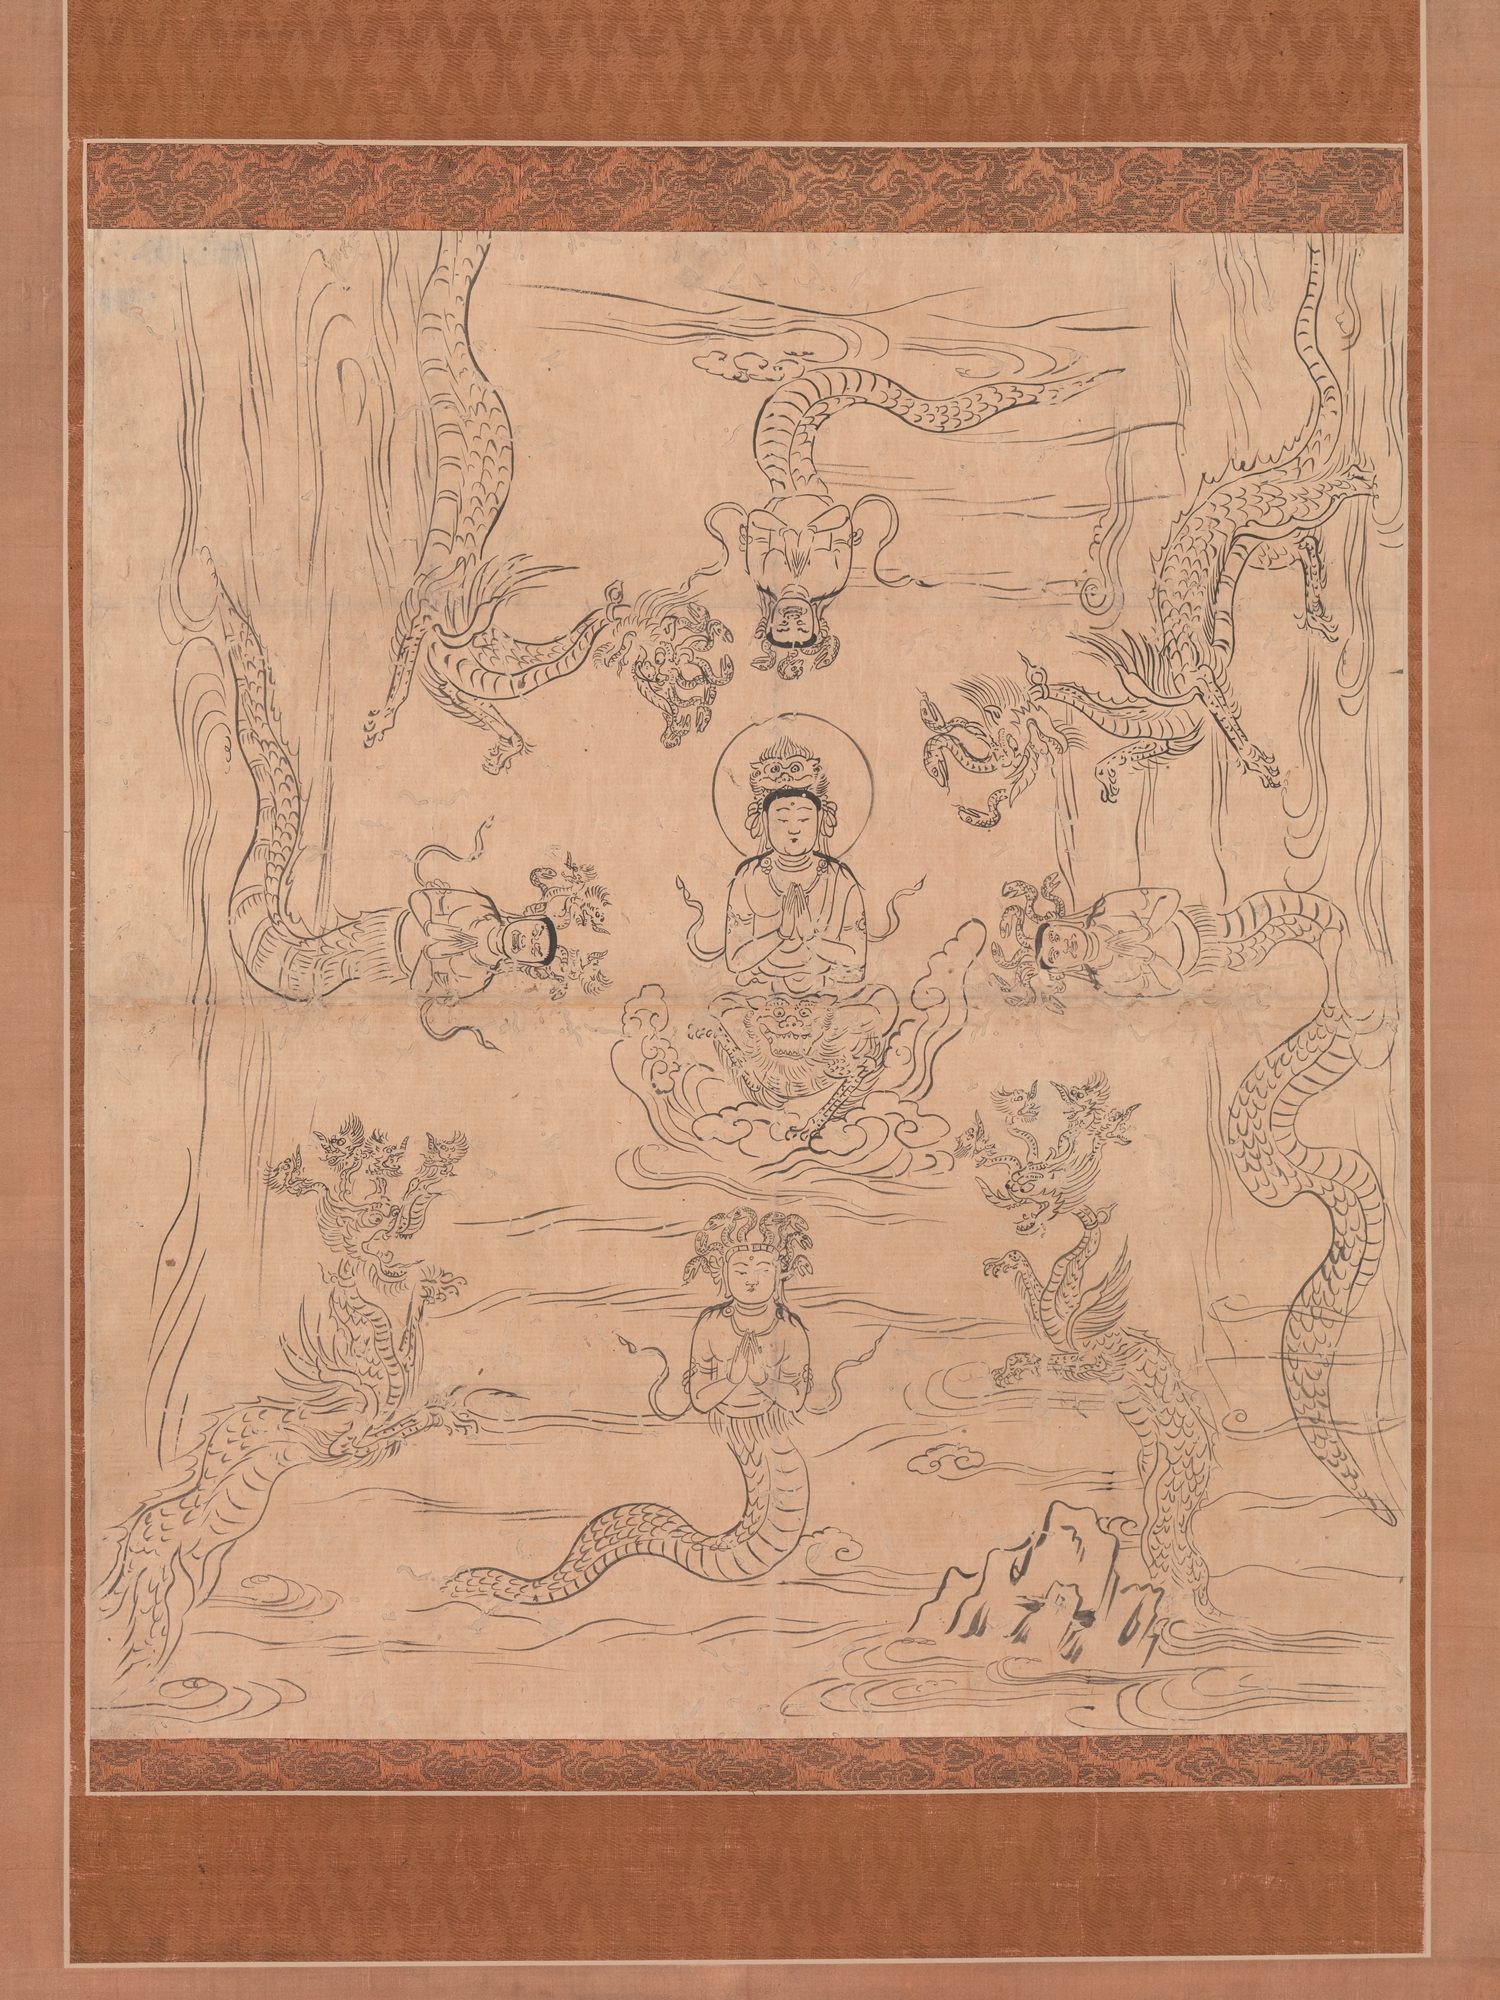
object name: hanging scroll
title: Iconographic Drawing of a Rainmaking Mandala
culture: japanese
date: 1101-1200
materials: ink, paper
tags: mythical creatures,dragons,buddhism,bodhisattvas